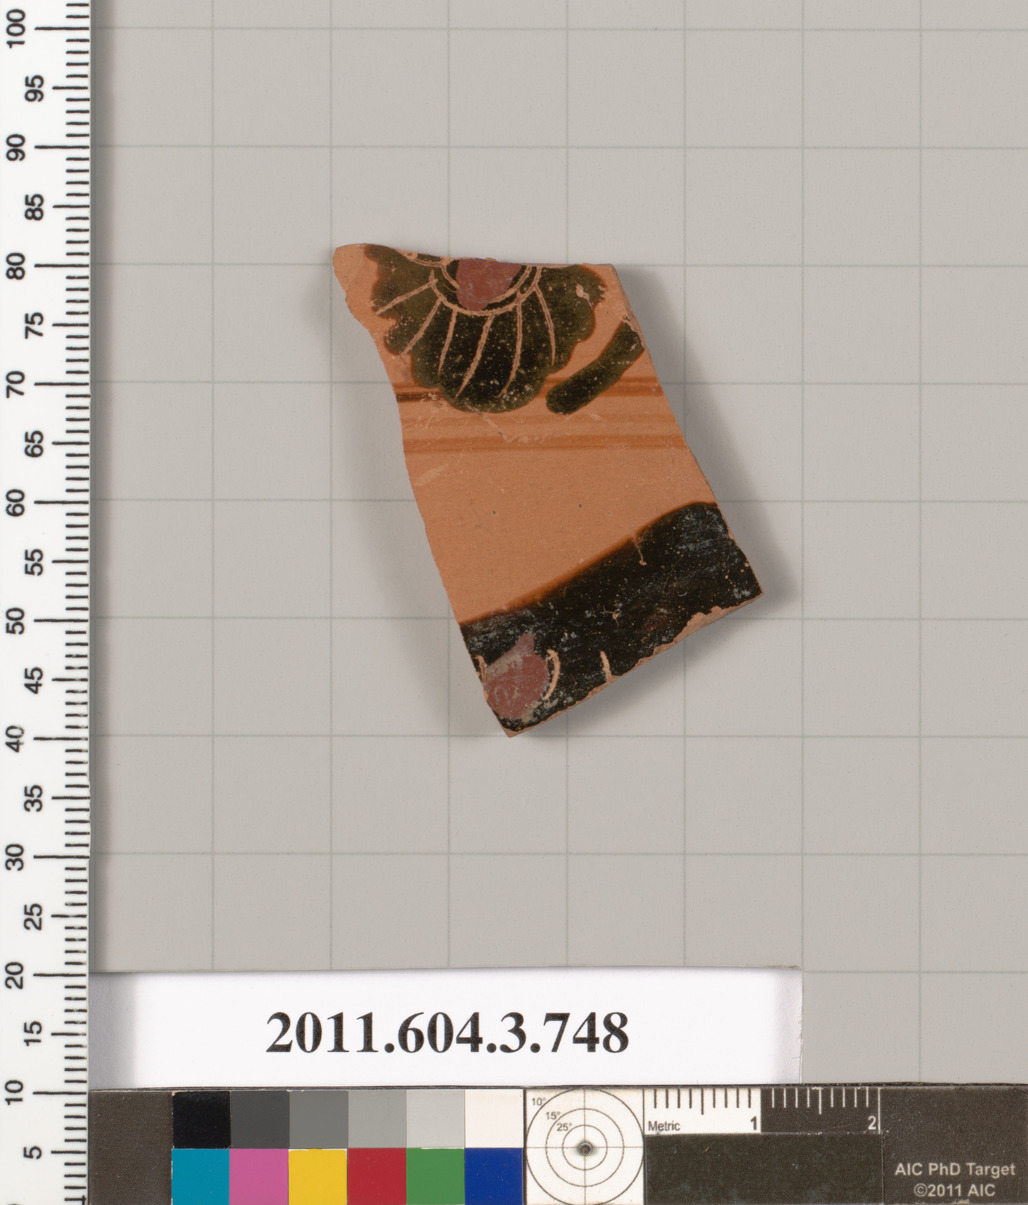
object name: neck amphora, tyrrhenian fragment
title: Terracotta fragment of a neck-amphora (jar)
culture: greek, attic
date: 575-551 BCE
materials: terracotta